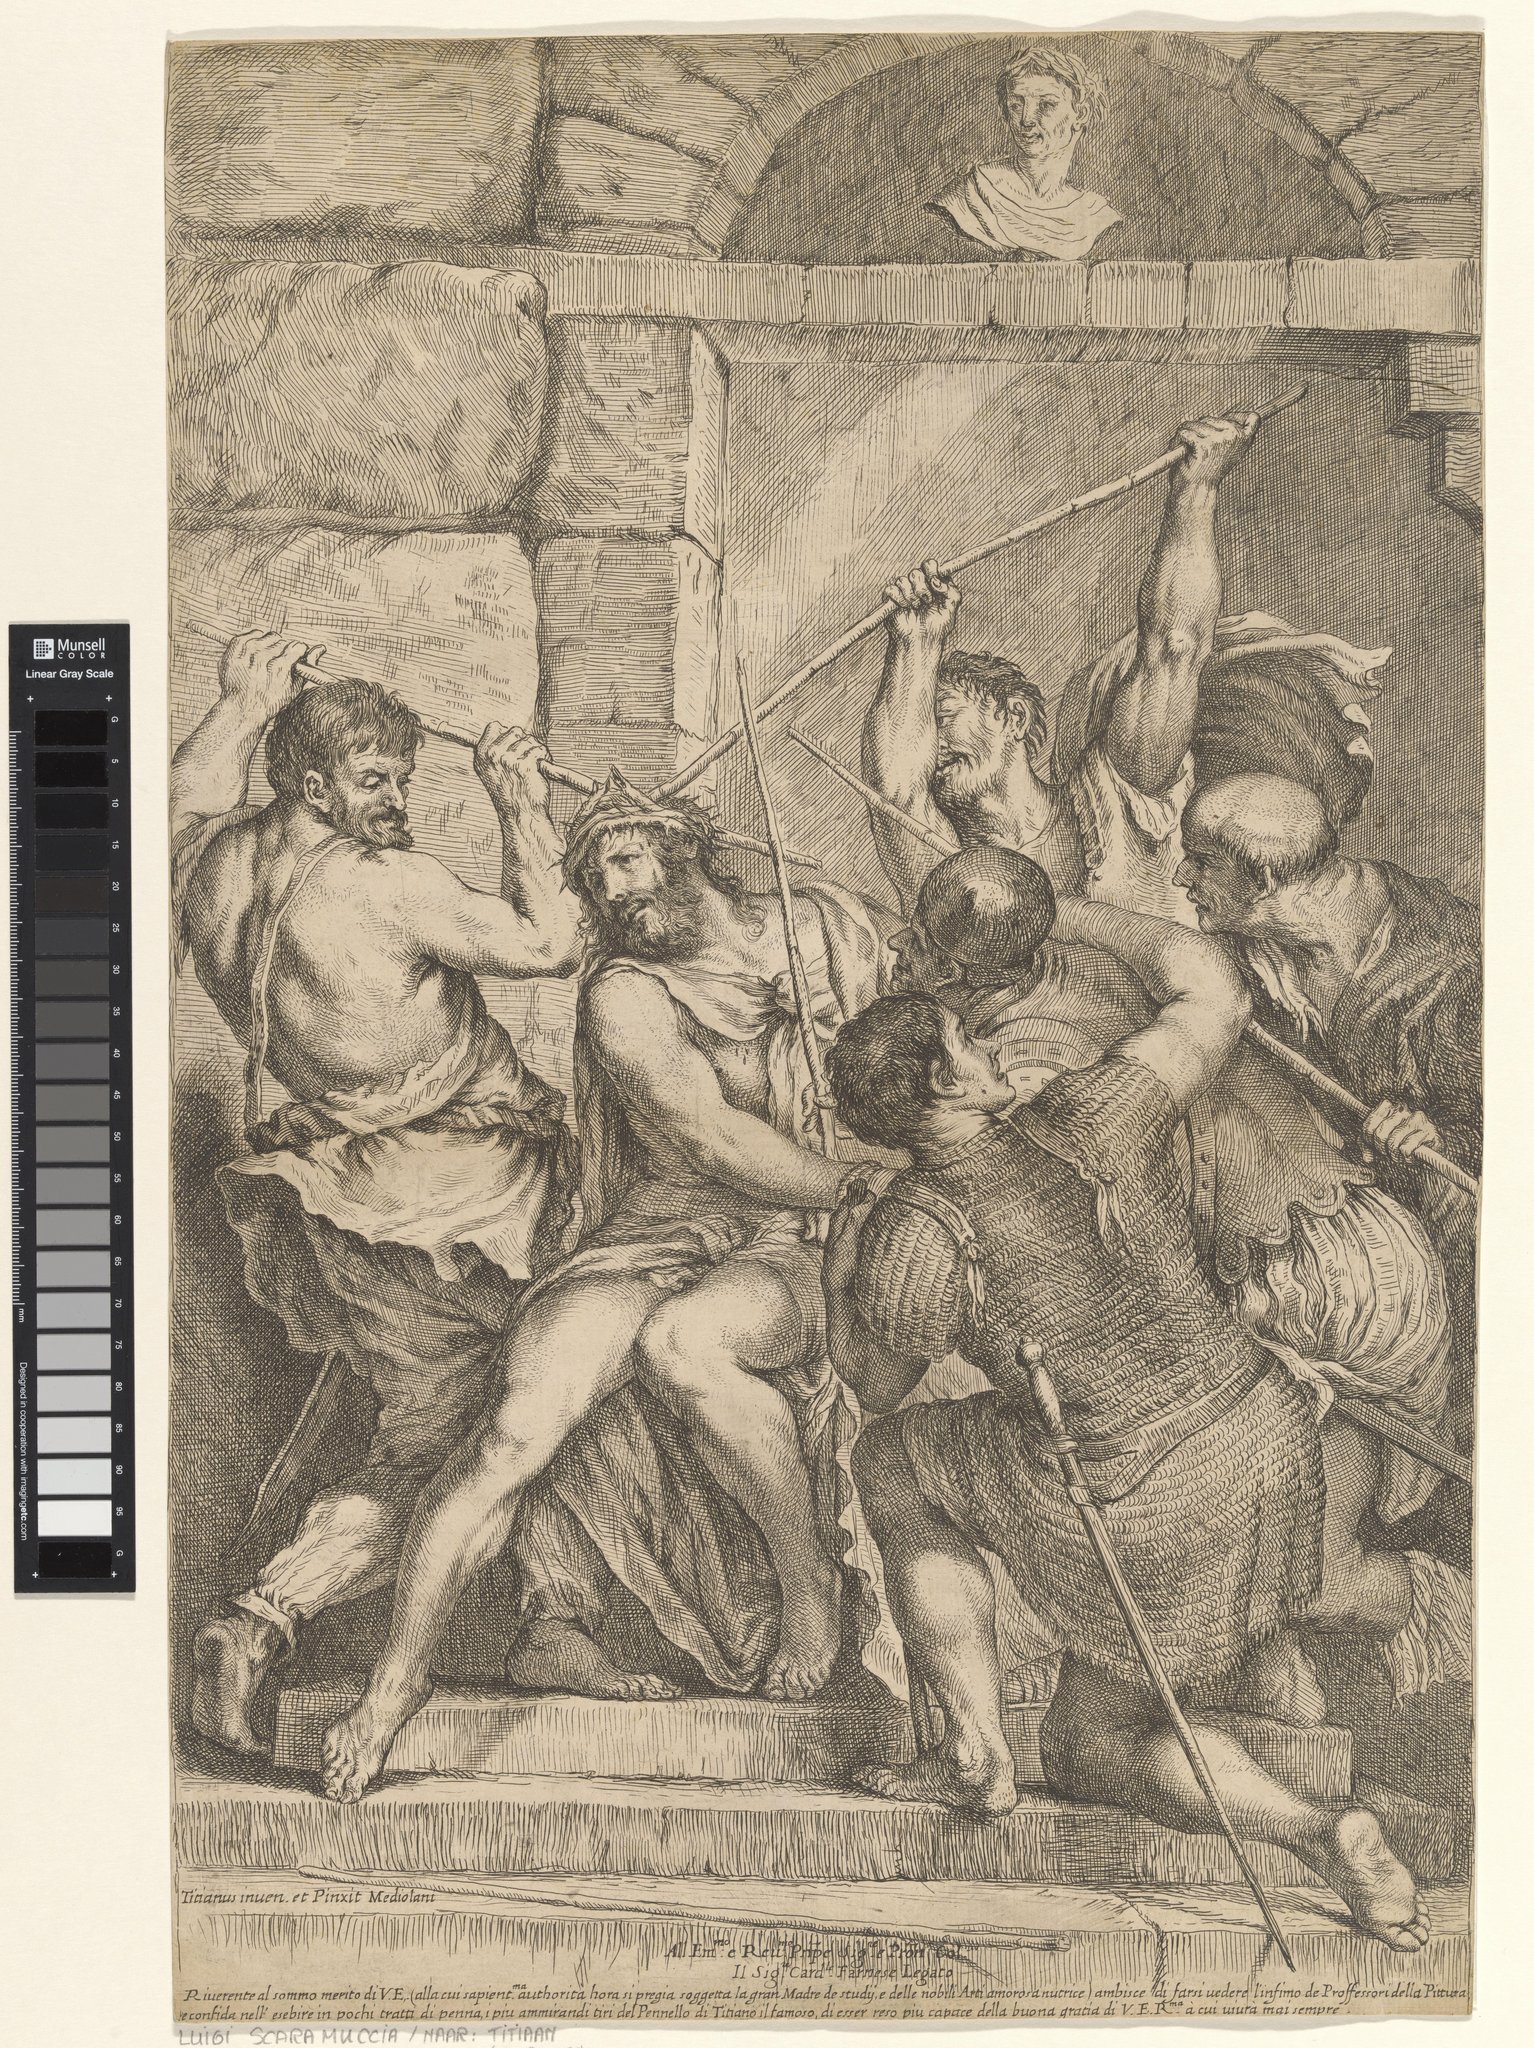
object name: print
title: Doornenkroning van Christus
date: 1626-1680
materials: paper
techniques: etching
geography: milan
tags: the crowning with thorns: soldiers with sticks place a thorny crown on christ's head and give him a reed (matthew 27:27-31; mark 15:16-20; john 19:2-3)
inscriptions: collector's mark: Lugt 2228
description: Prent naar een schilderij gemaakt door Titiaan voor de Santa Maria delle Grazie te Milaan dat zich nu bevindt in het Musée du Louvre te Parijs.